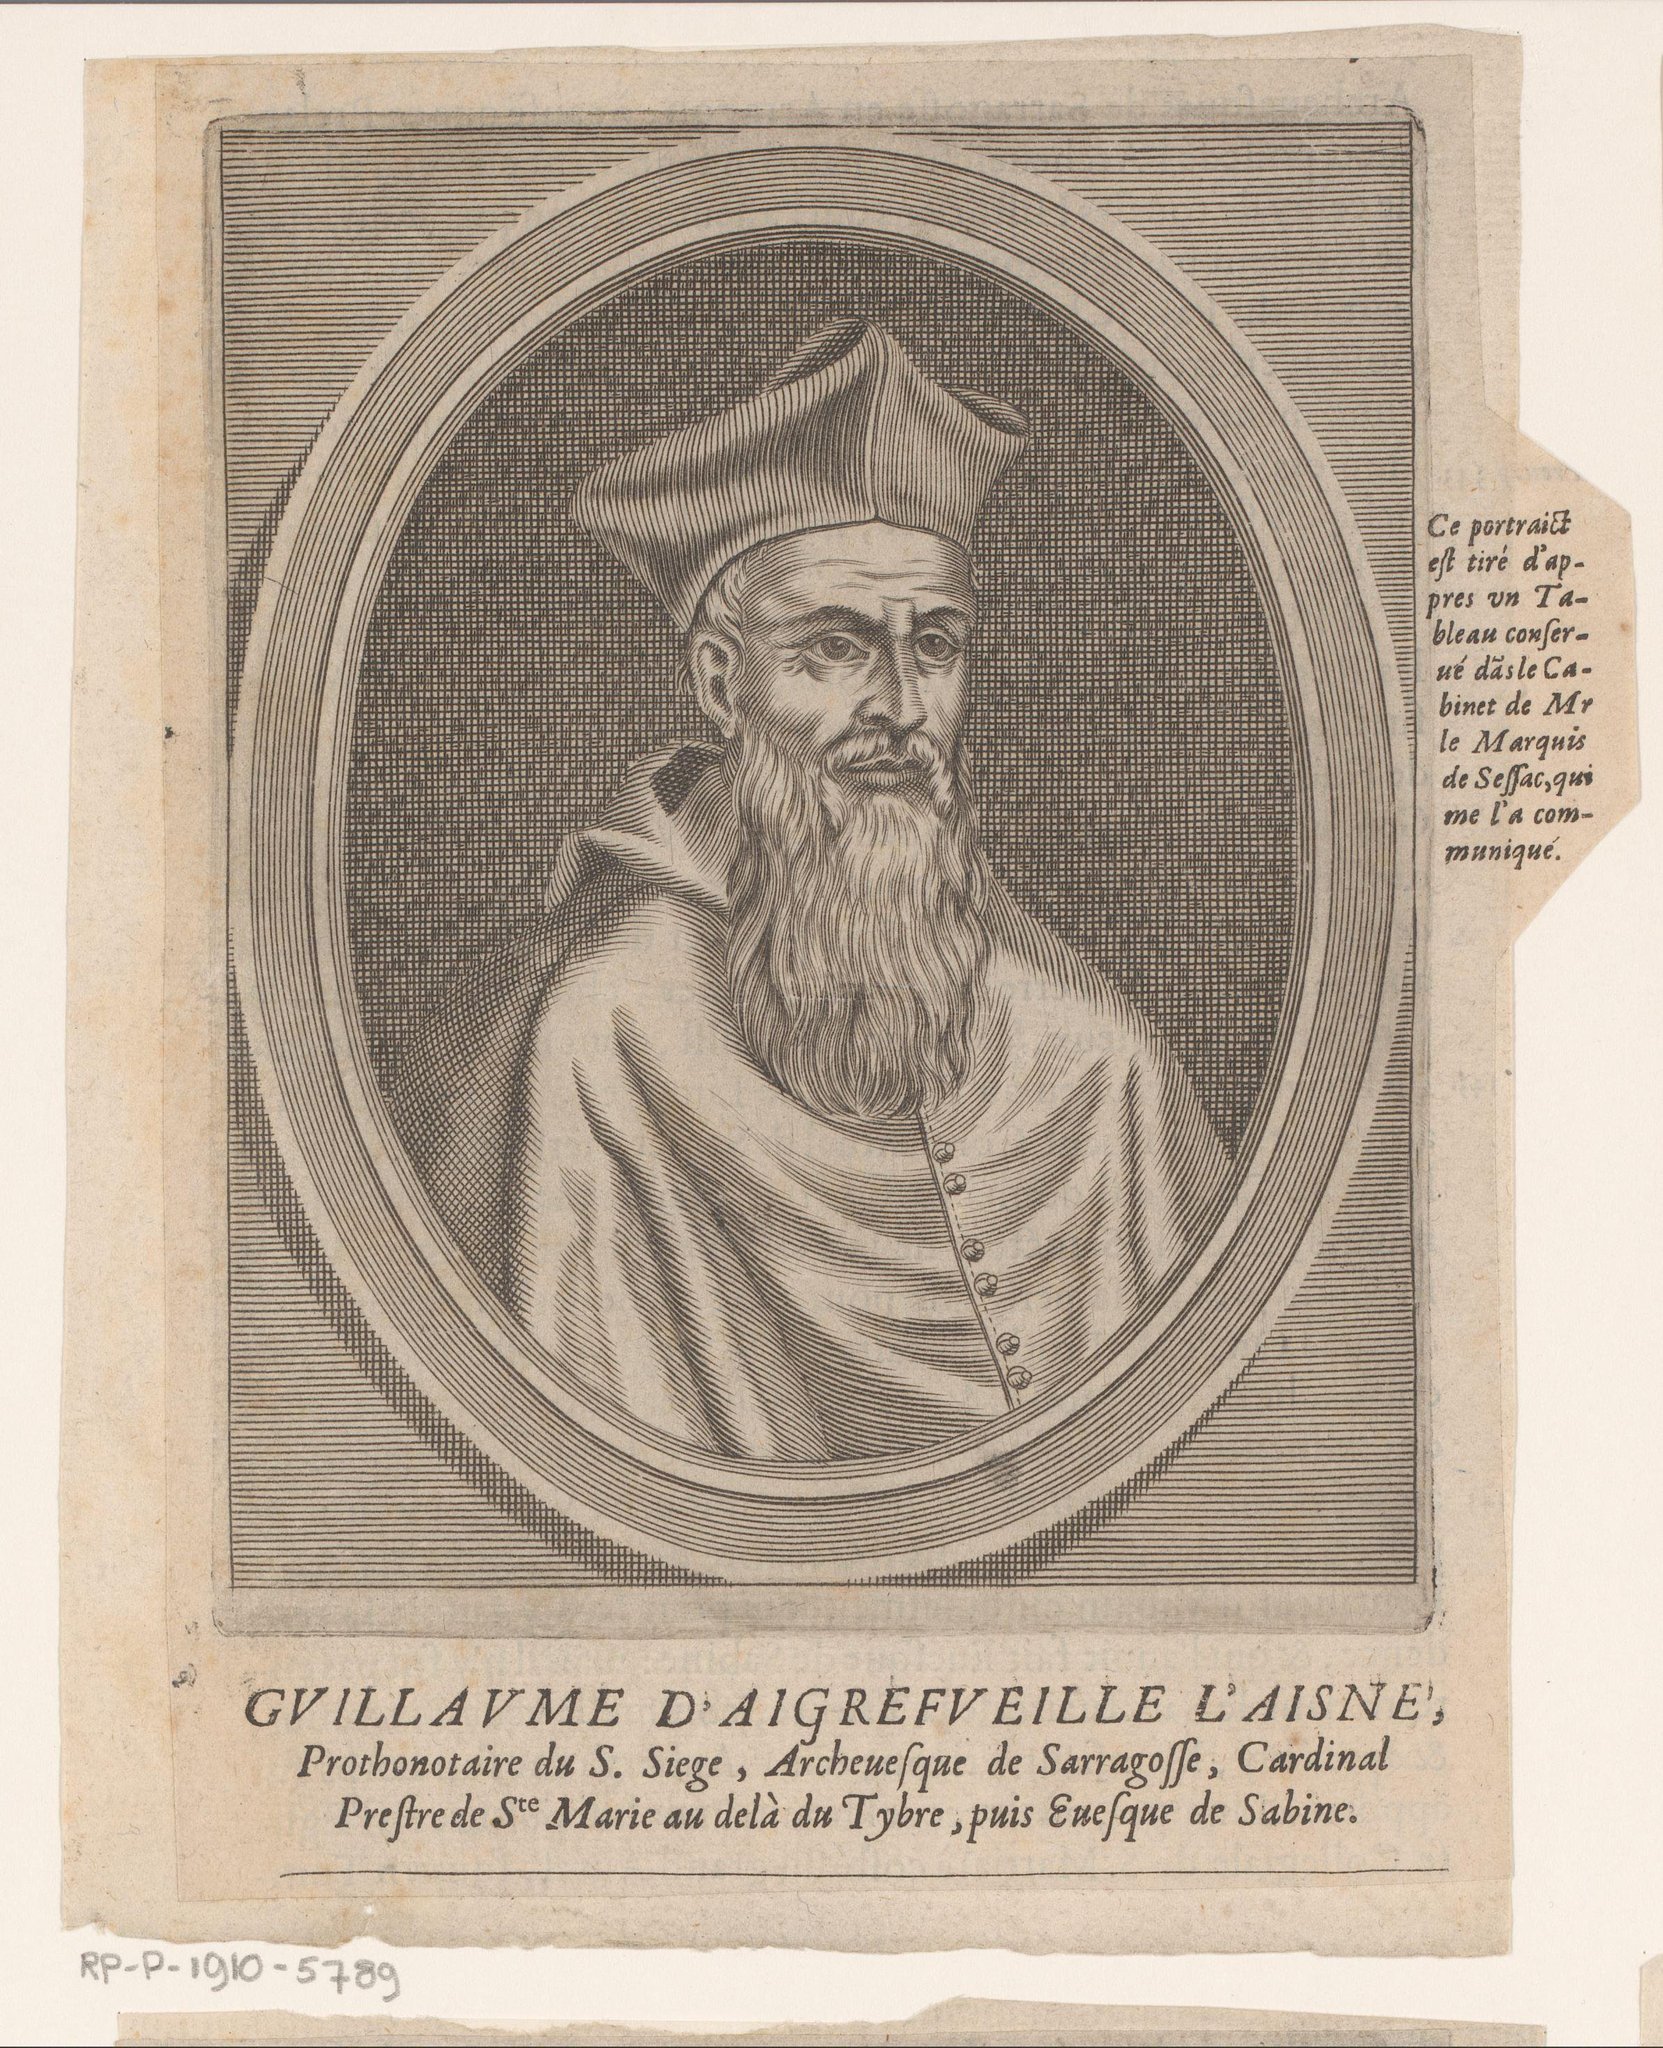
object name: print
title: Portret van Guillaume d'Aigrefeuille l'Ancien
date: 1660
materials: paper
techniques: engraving, etching, letterpress printing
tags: archbishop, bishop, etc. (roman catholic), historical persons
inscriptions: collector's mark: Lugt 2228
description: Prent uit: Du Chesne, François. Histoire de tous les cardinaux françois de naissance, ou qui ont esté promeus au cardinalat. Parijs: François Du Chesne, 1660.